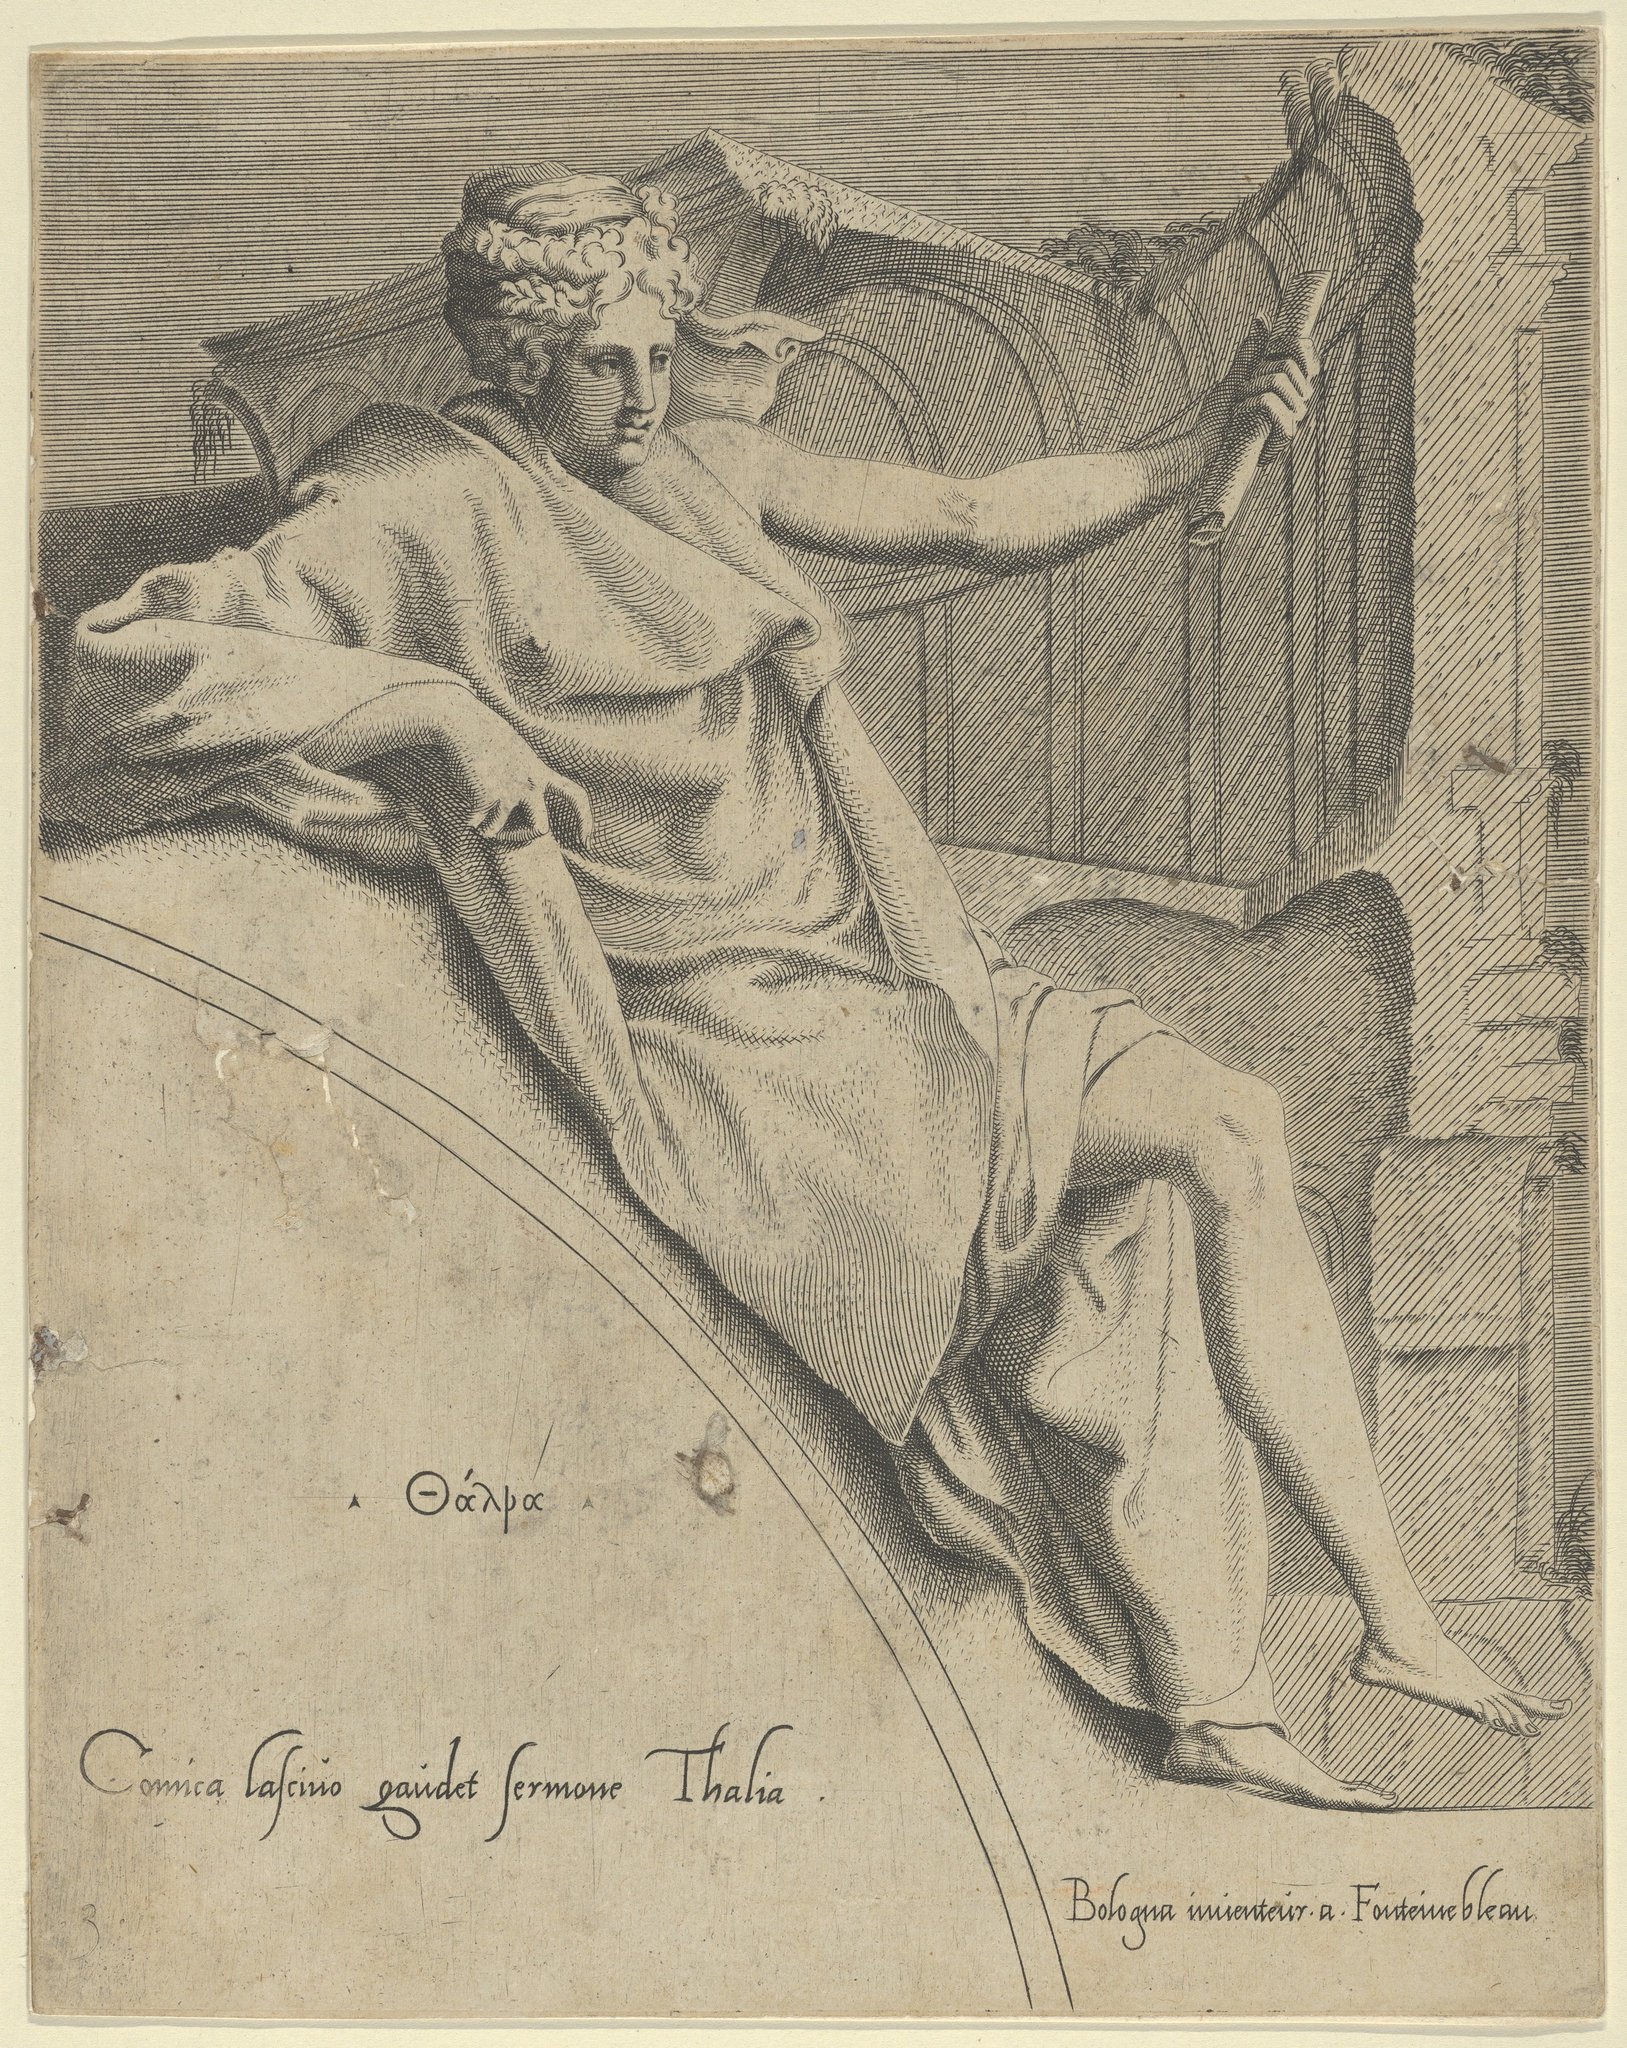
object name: print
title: Thalia, from "The Muses and the Three Great Goddesses"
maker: anonymous, italian, 16th century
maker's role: artist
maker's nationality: italian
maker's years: 1550-1600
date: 1540-1545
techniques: engraving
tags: women